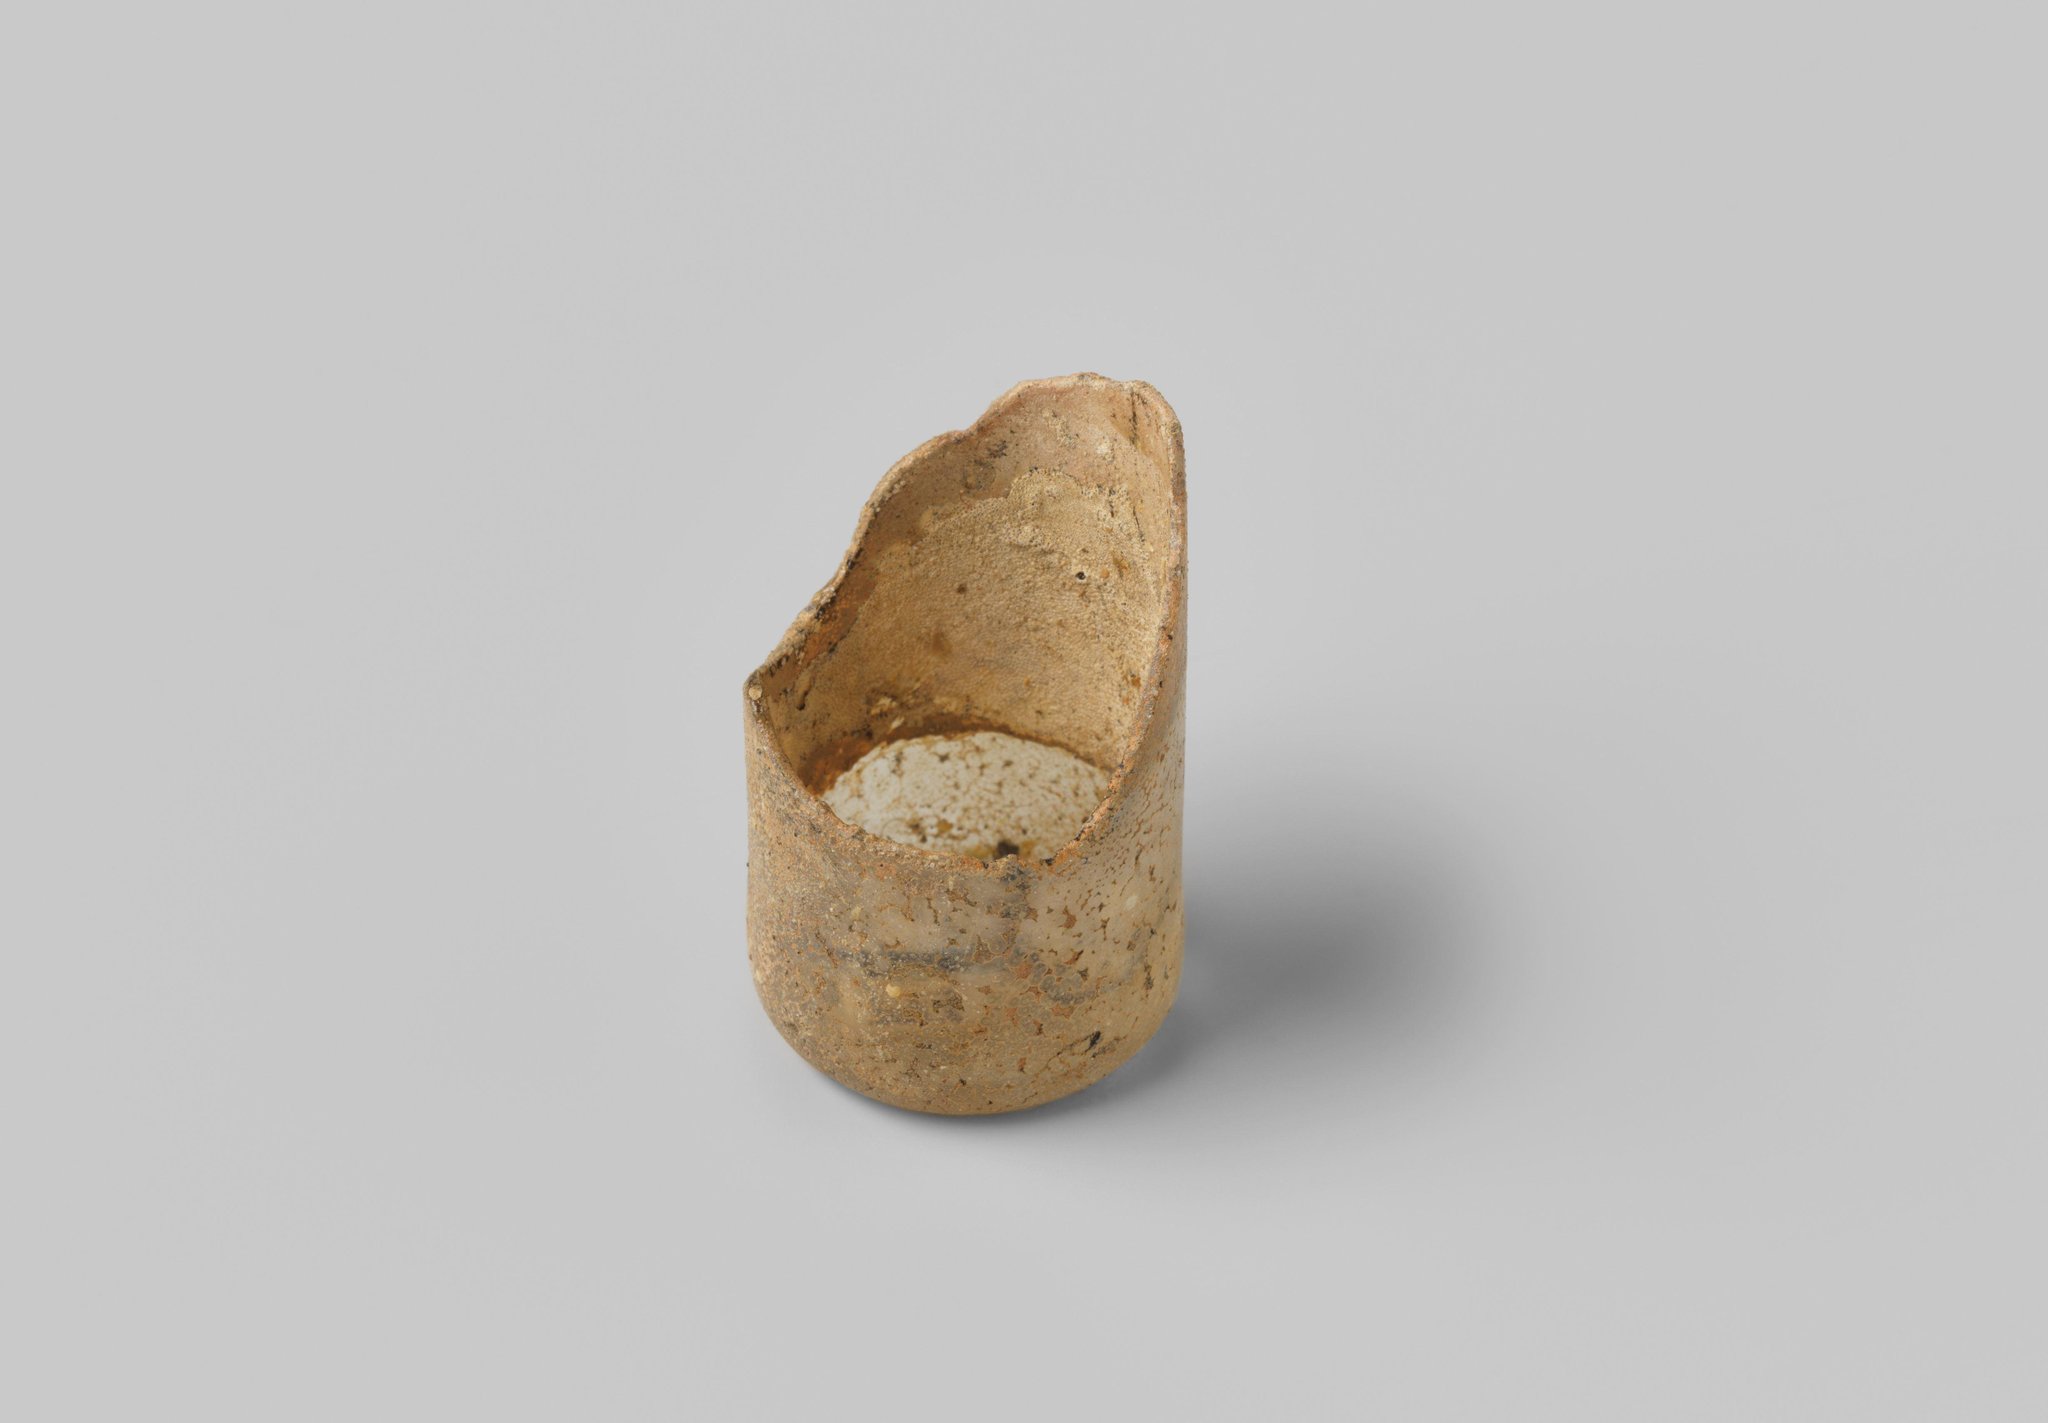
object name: medicine bottle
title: Fragment medicijnfles uit V.O.C.-schip de 'Witte Leeuw'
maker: Anonymous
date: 1613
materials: glass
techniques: green glass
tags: verenigde oostindische compagnie, sint-helena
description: Scherf van medicijnfles uit V.O.C.-schip de 'Witte Leeuw', flessenbodem van groen glas.